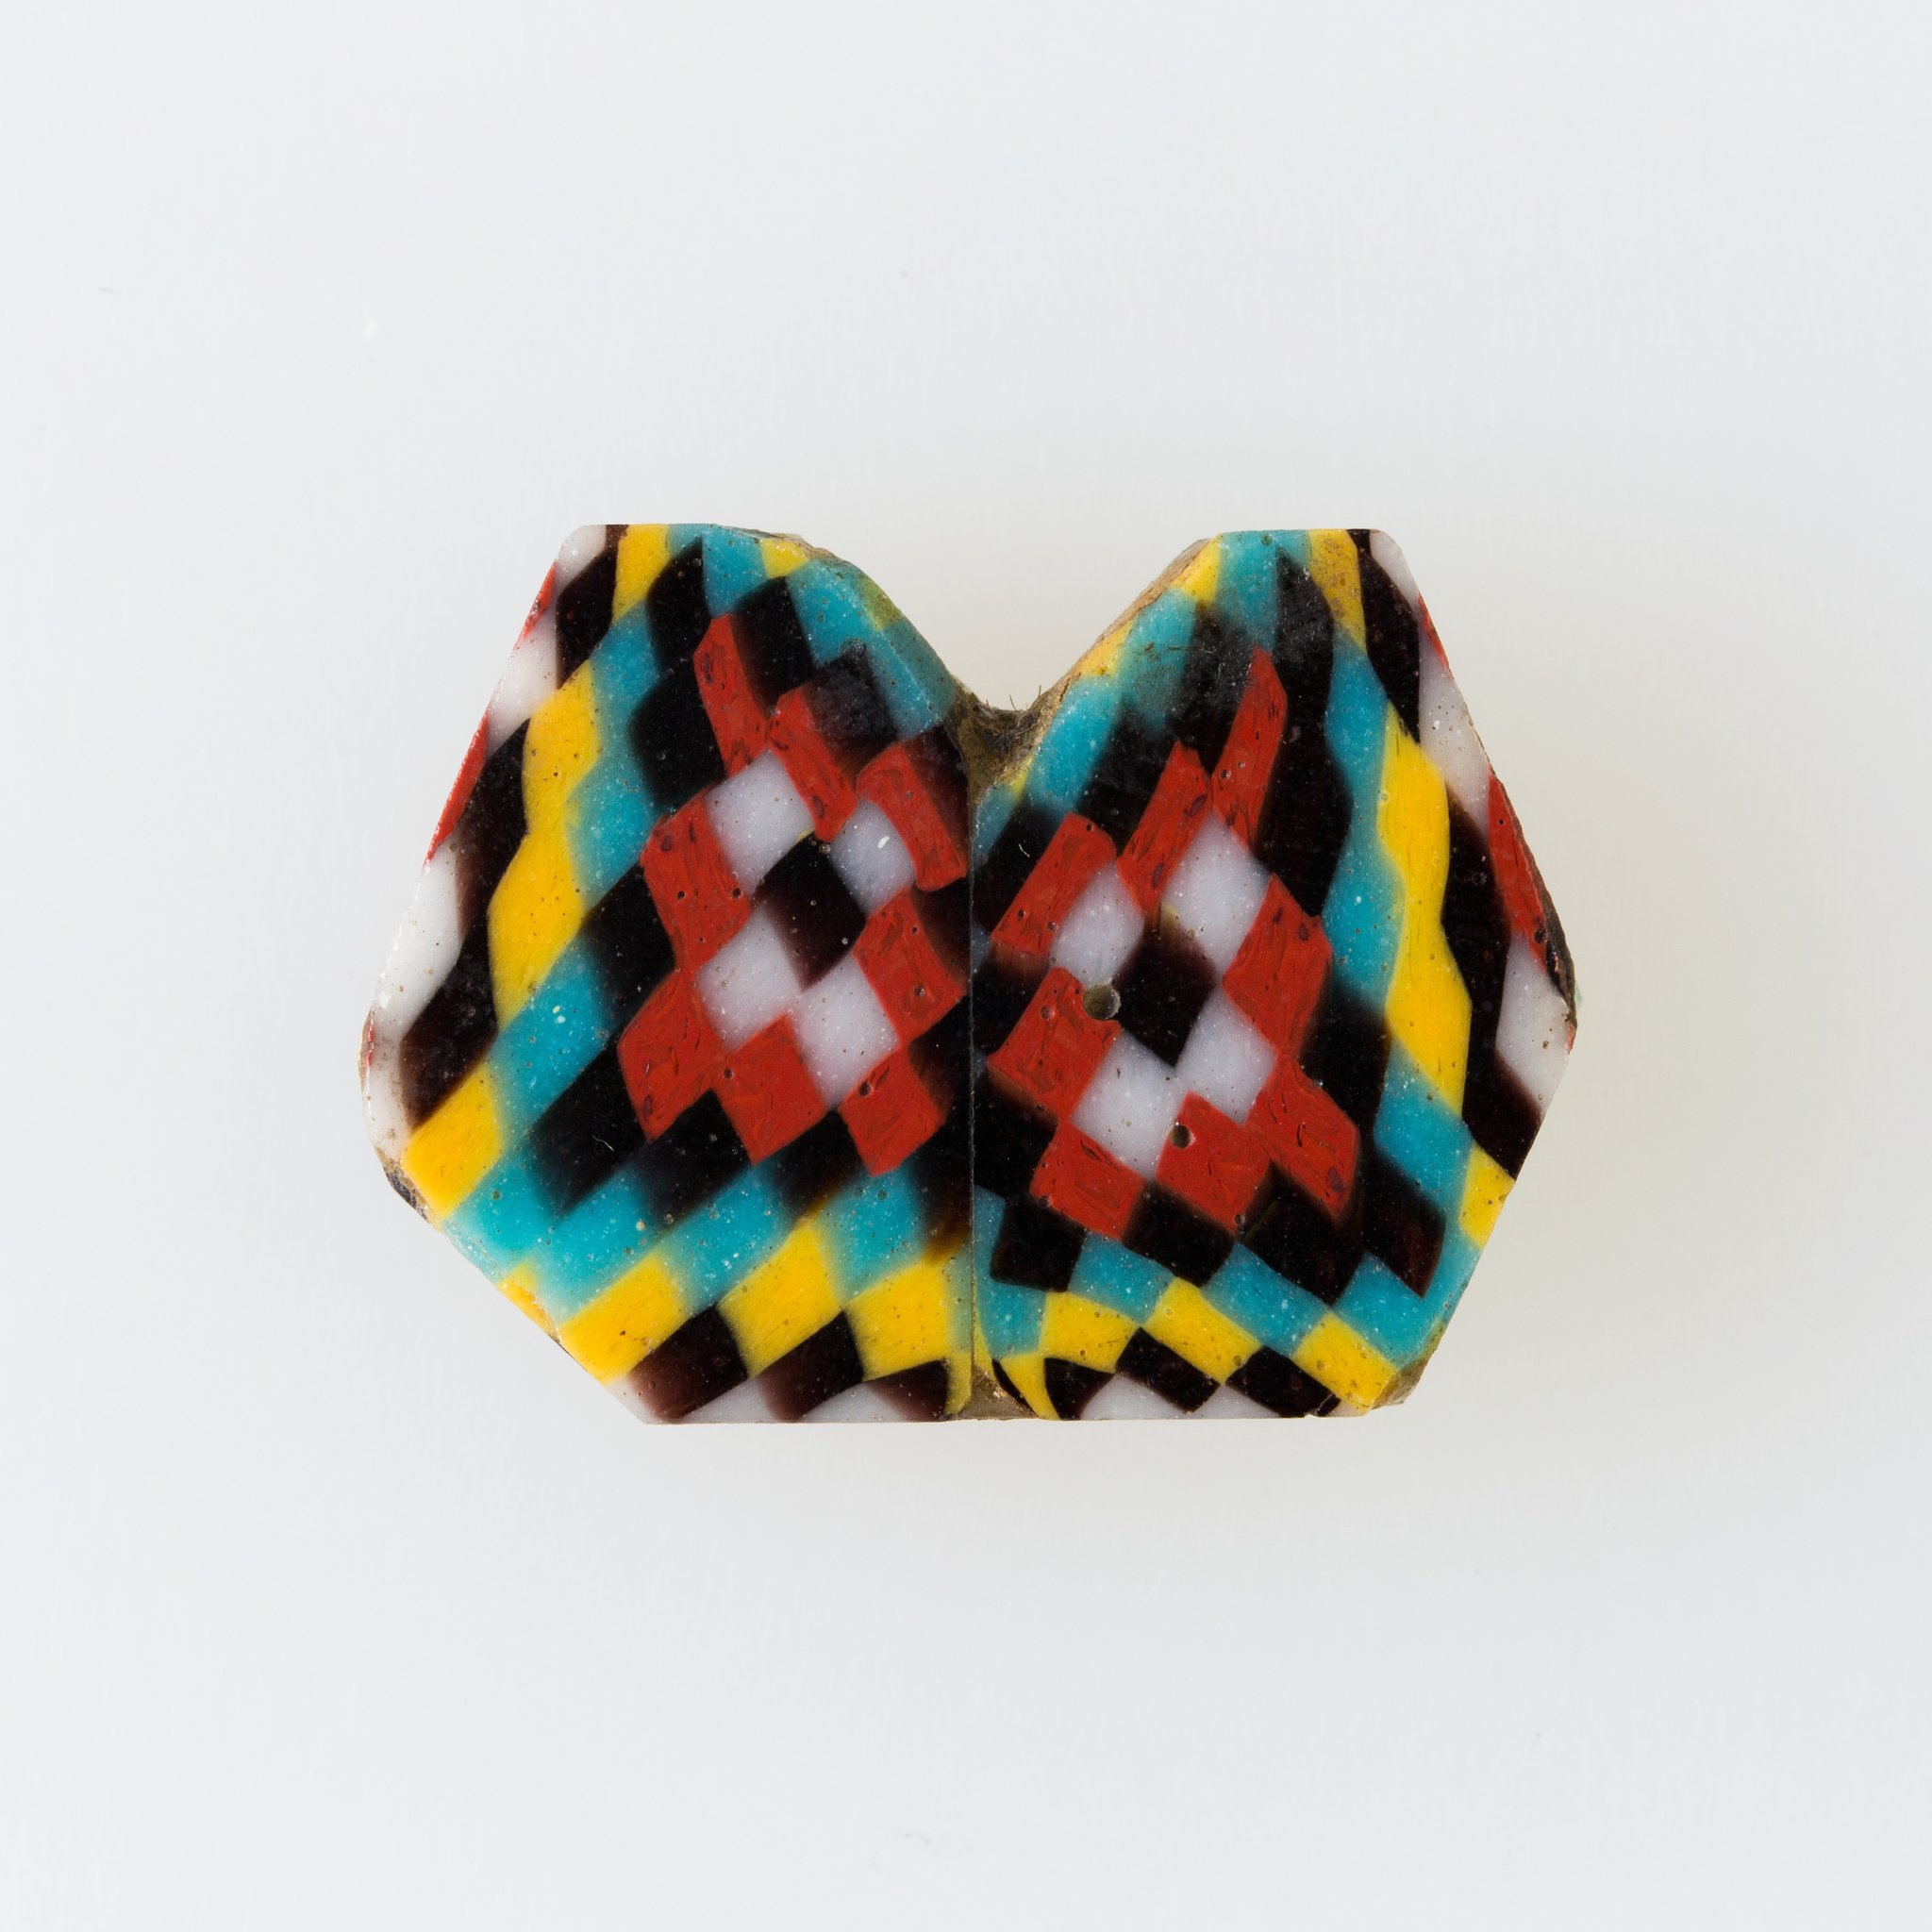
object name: inlay, pattern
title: Inlay, pattern of squares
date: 100 BCE-100 CE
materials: glass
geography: egypt